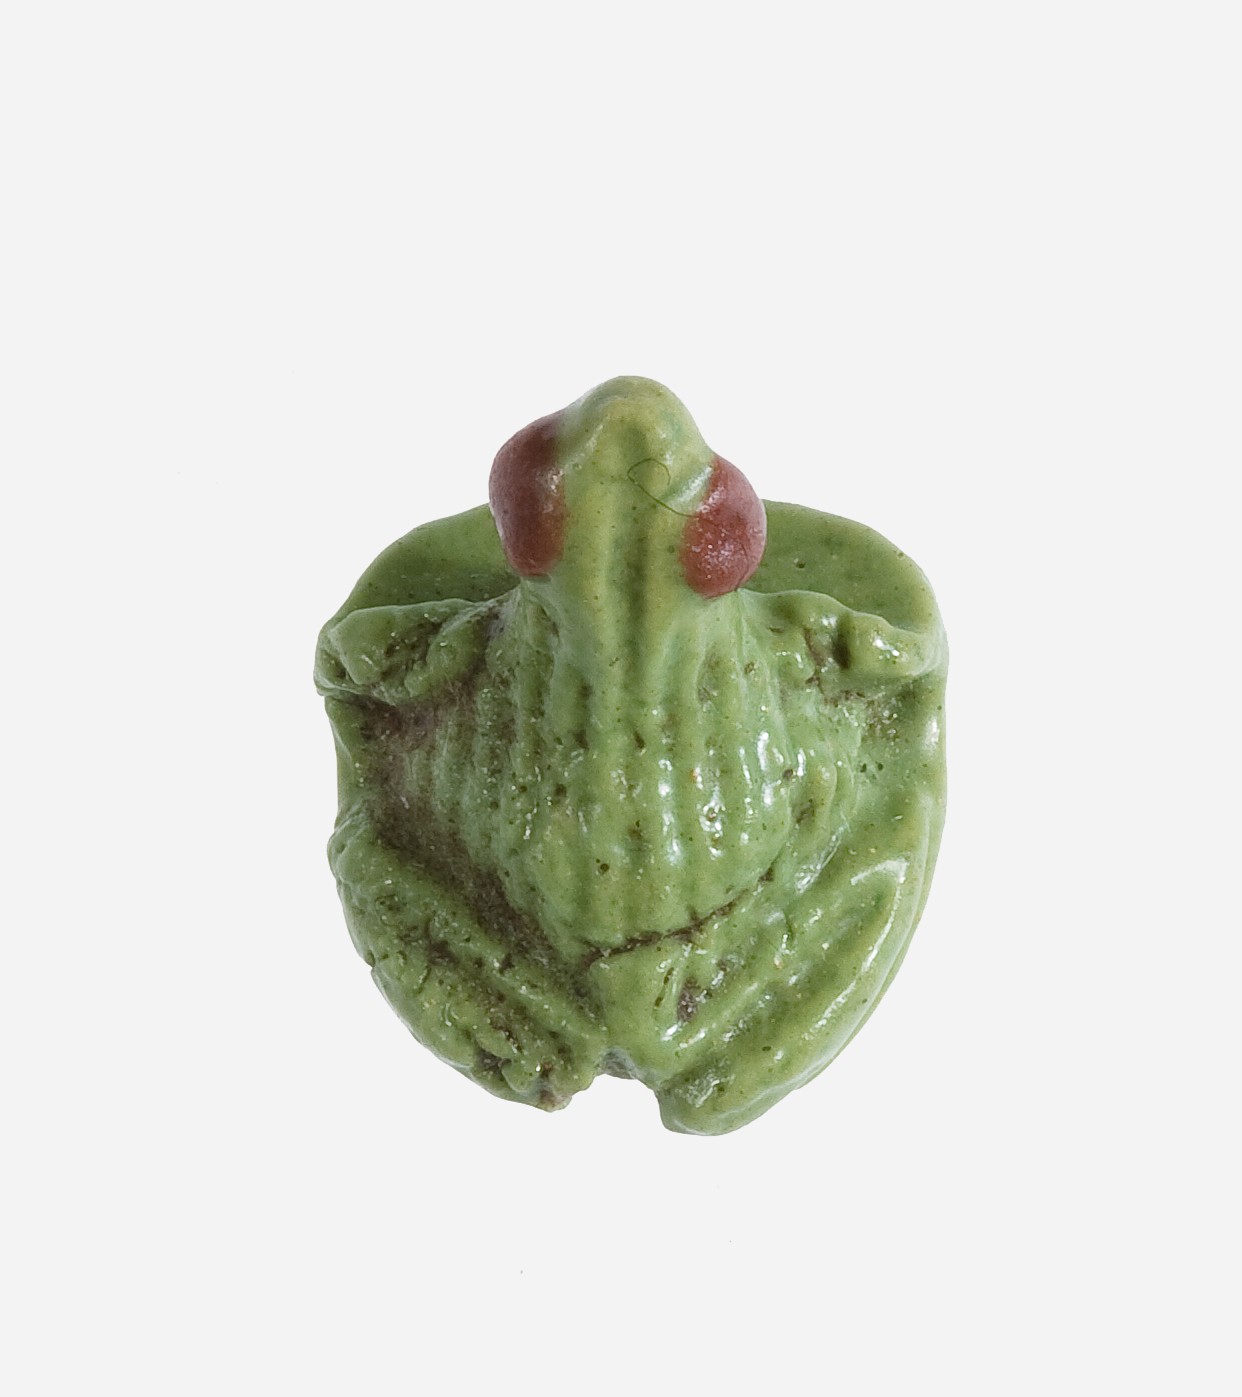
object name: stamp seal, frog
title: Frog Seal Amulet with an Ankh Hieroglyph on the Base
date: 1390-1352 BCE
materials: faience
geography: egypt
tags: hieroglyphs,frogs